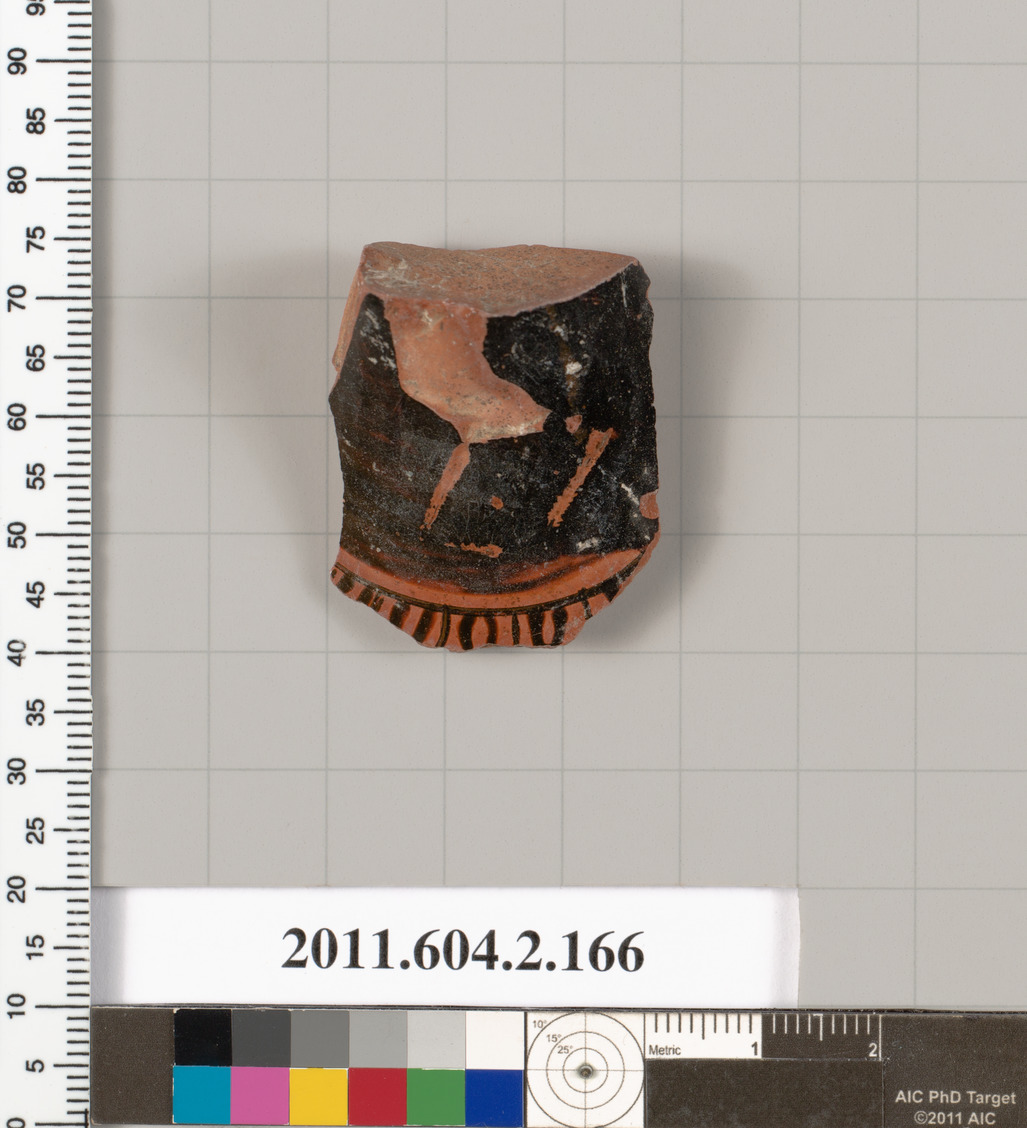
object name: stamnos fragment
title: Terracotta fragment of a stamnos (jar)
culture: greek, attic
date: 470-440 BCE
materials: terracotta